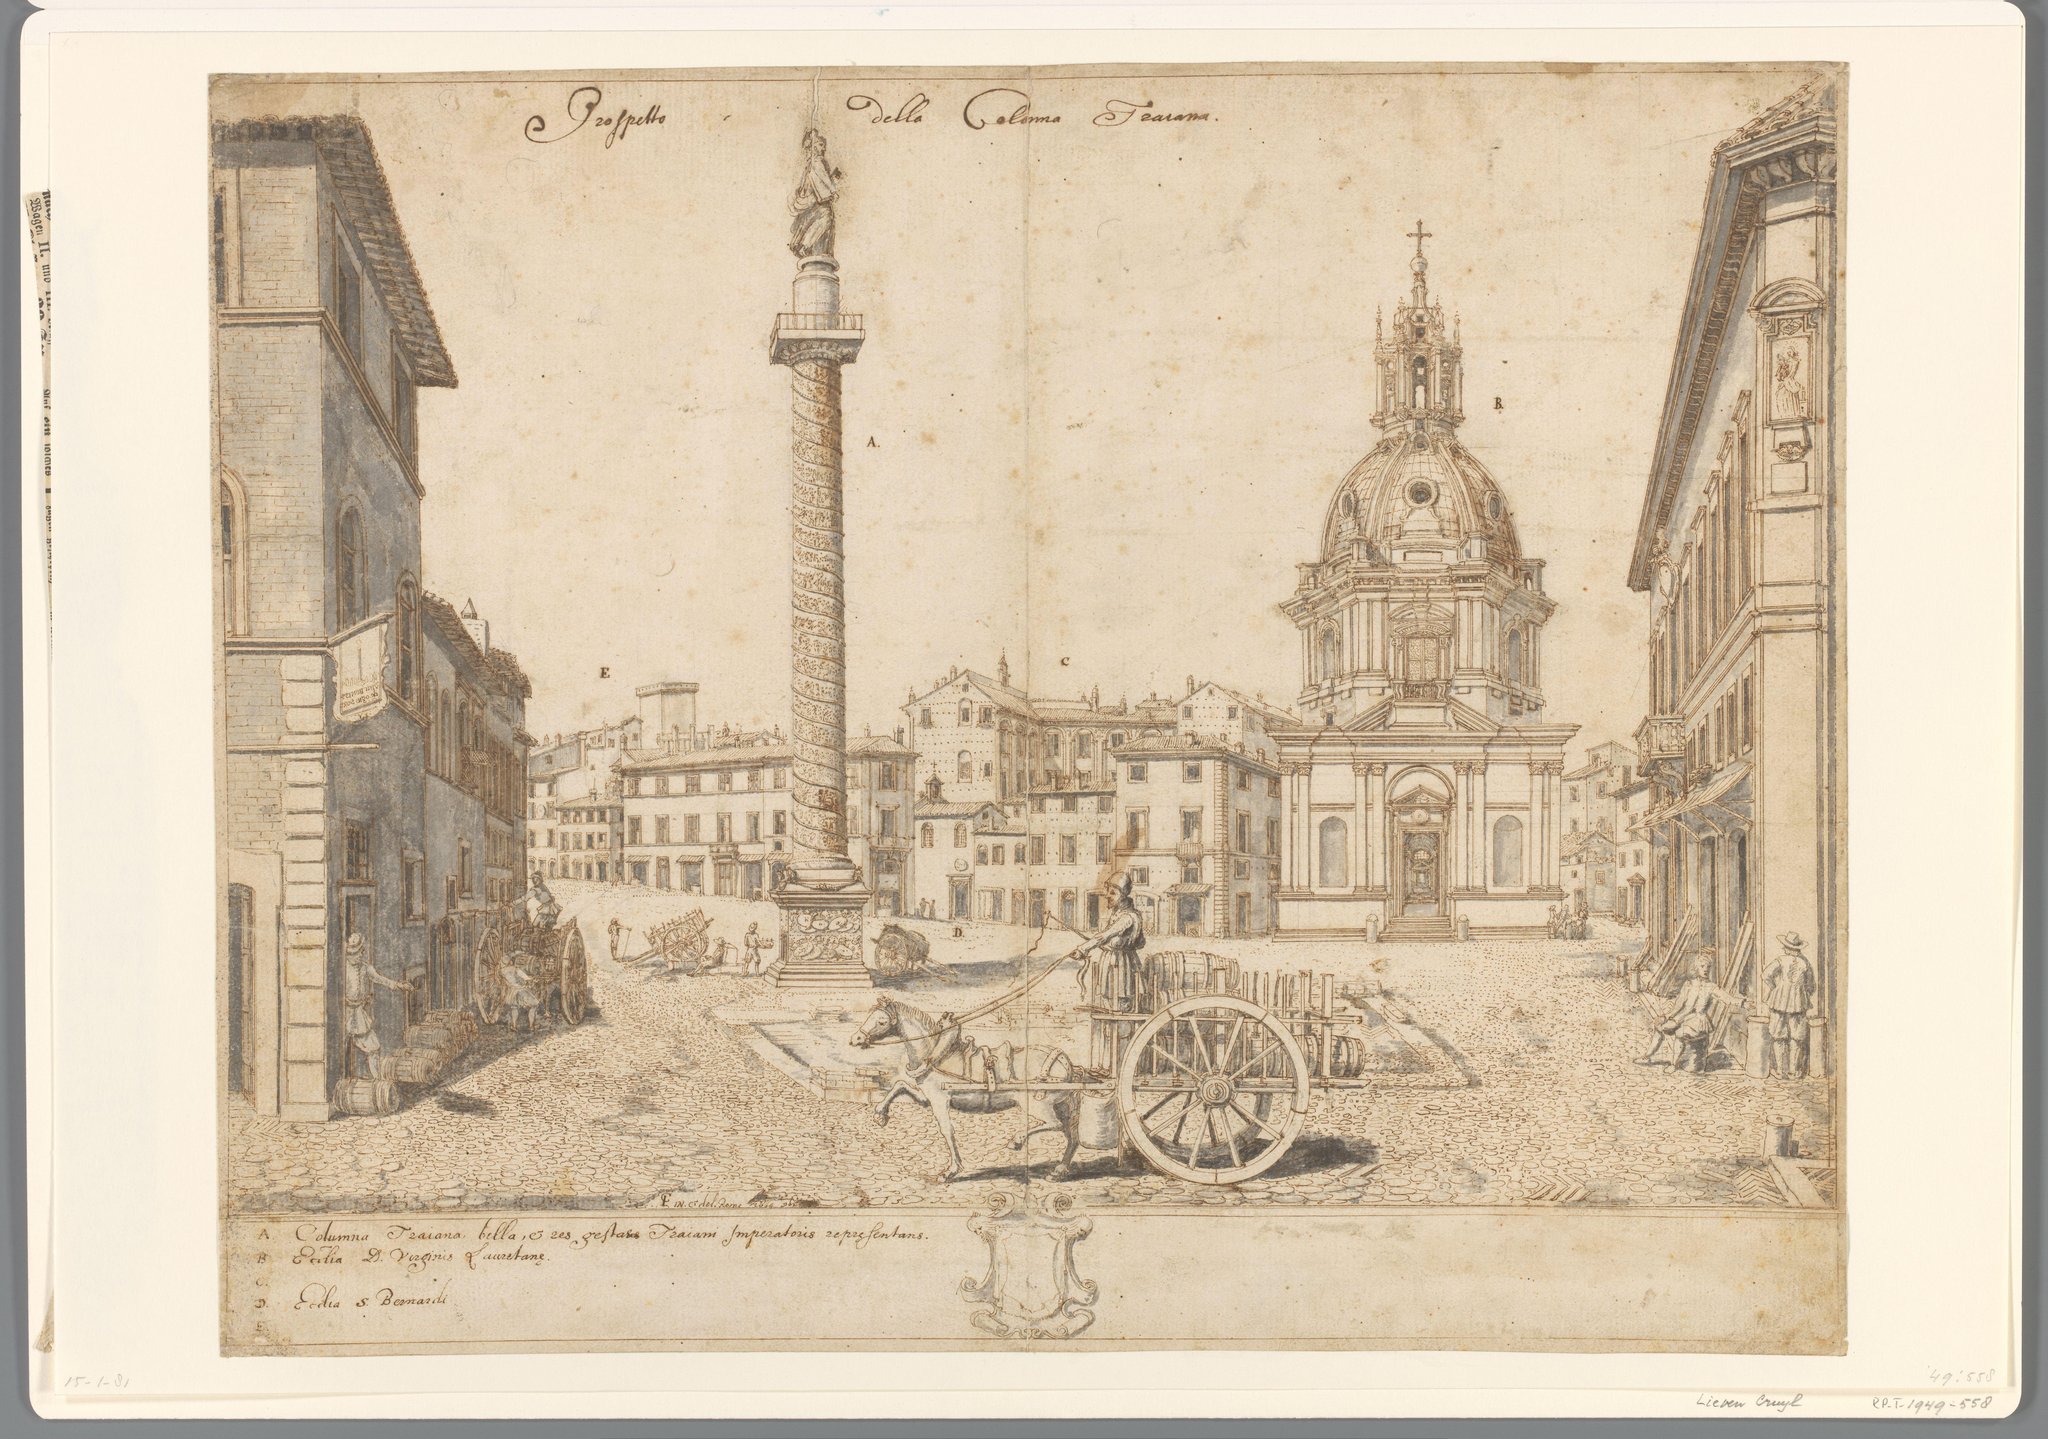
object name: drawing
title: Prospetto della Colonna Traiana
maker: lievin cruyl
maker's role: draughtsman, print maker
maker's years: 1634-1720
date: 1664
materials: ink, paper, pencil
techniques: brush, pen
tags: square, place, circus, etc., building of church, italy, rome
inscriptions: date: ‘1664’, : ‘Prospetto della Colonna Traiana’